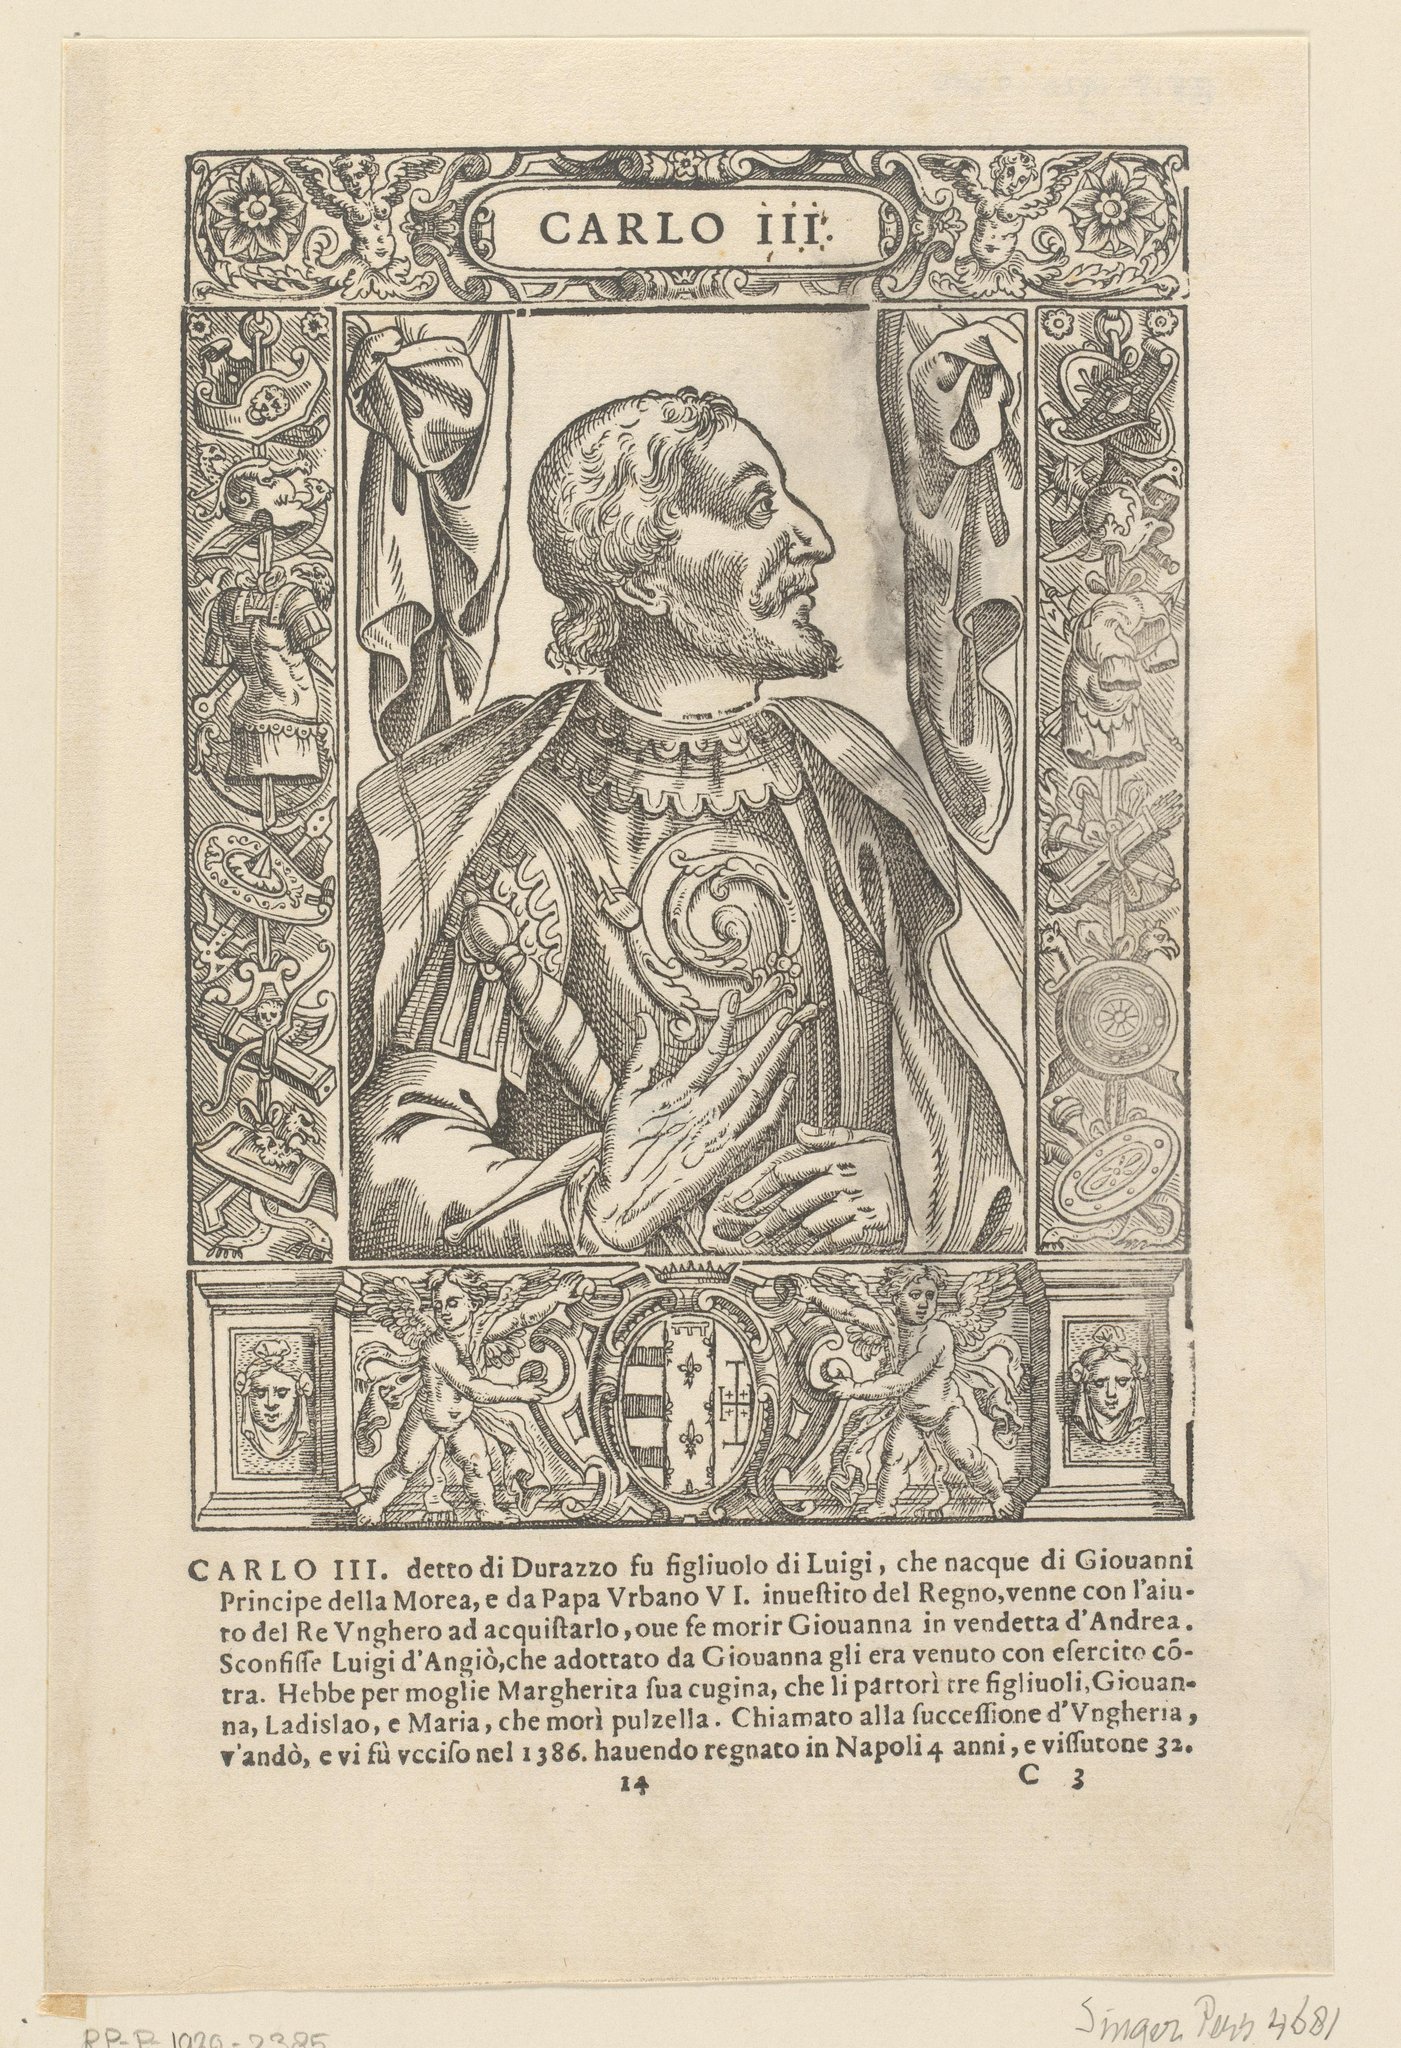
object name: print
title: Portret van Hendrik van Artois Bourbon, graaf van Chambord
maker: Anonymous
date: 1825-1835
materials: paper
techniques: lithograph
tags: historical persons